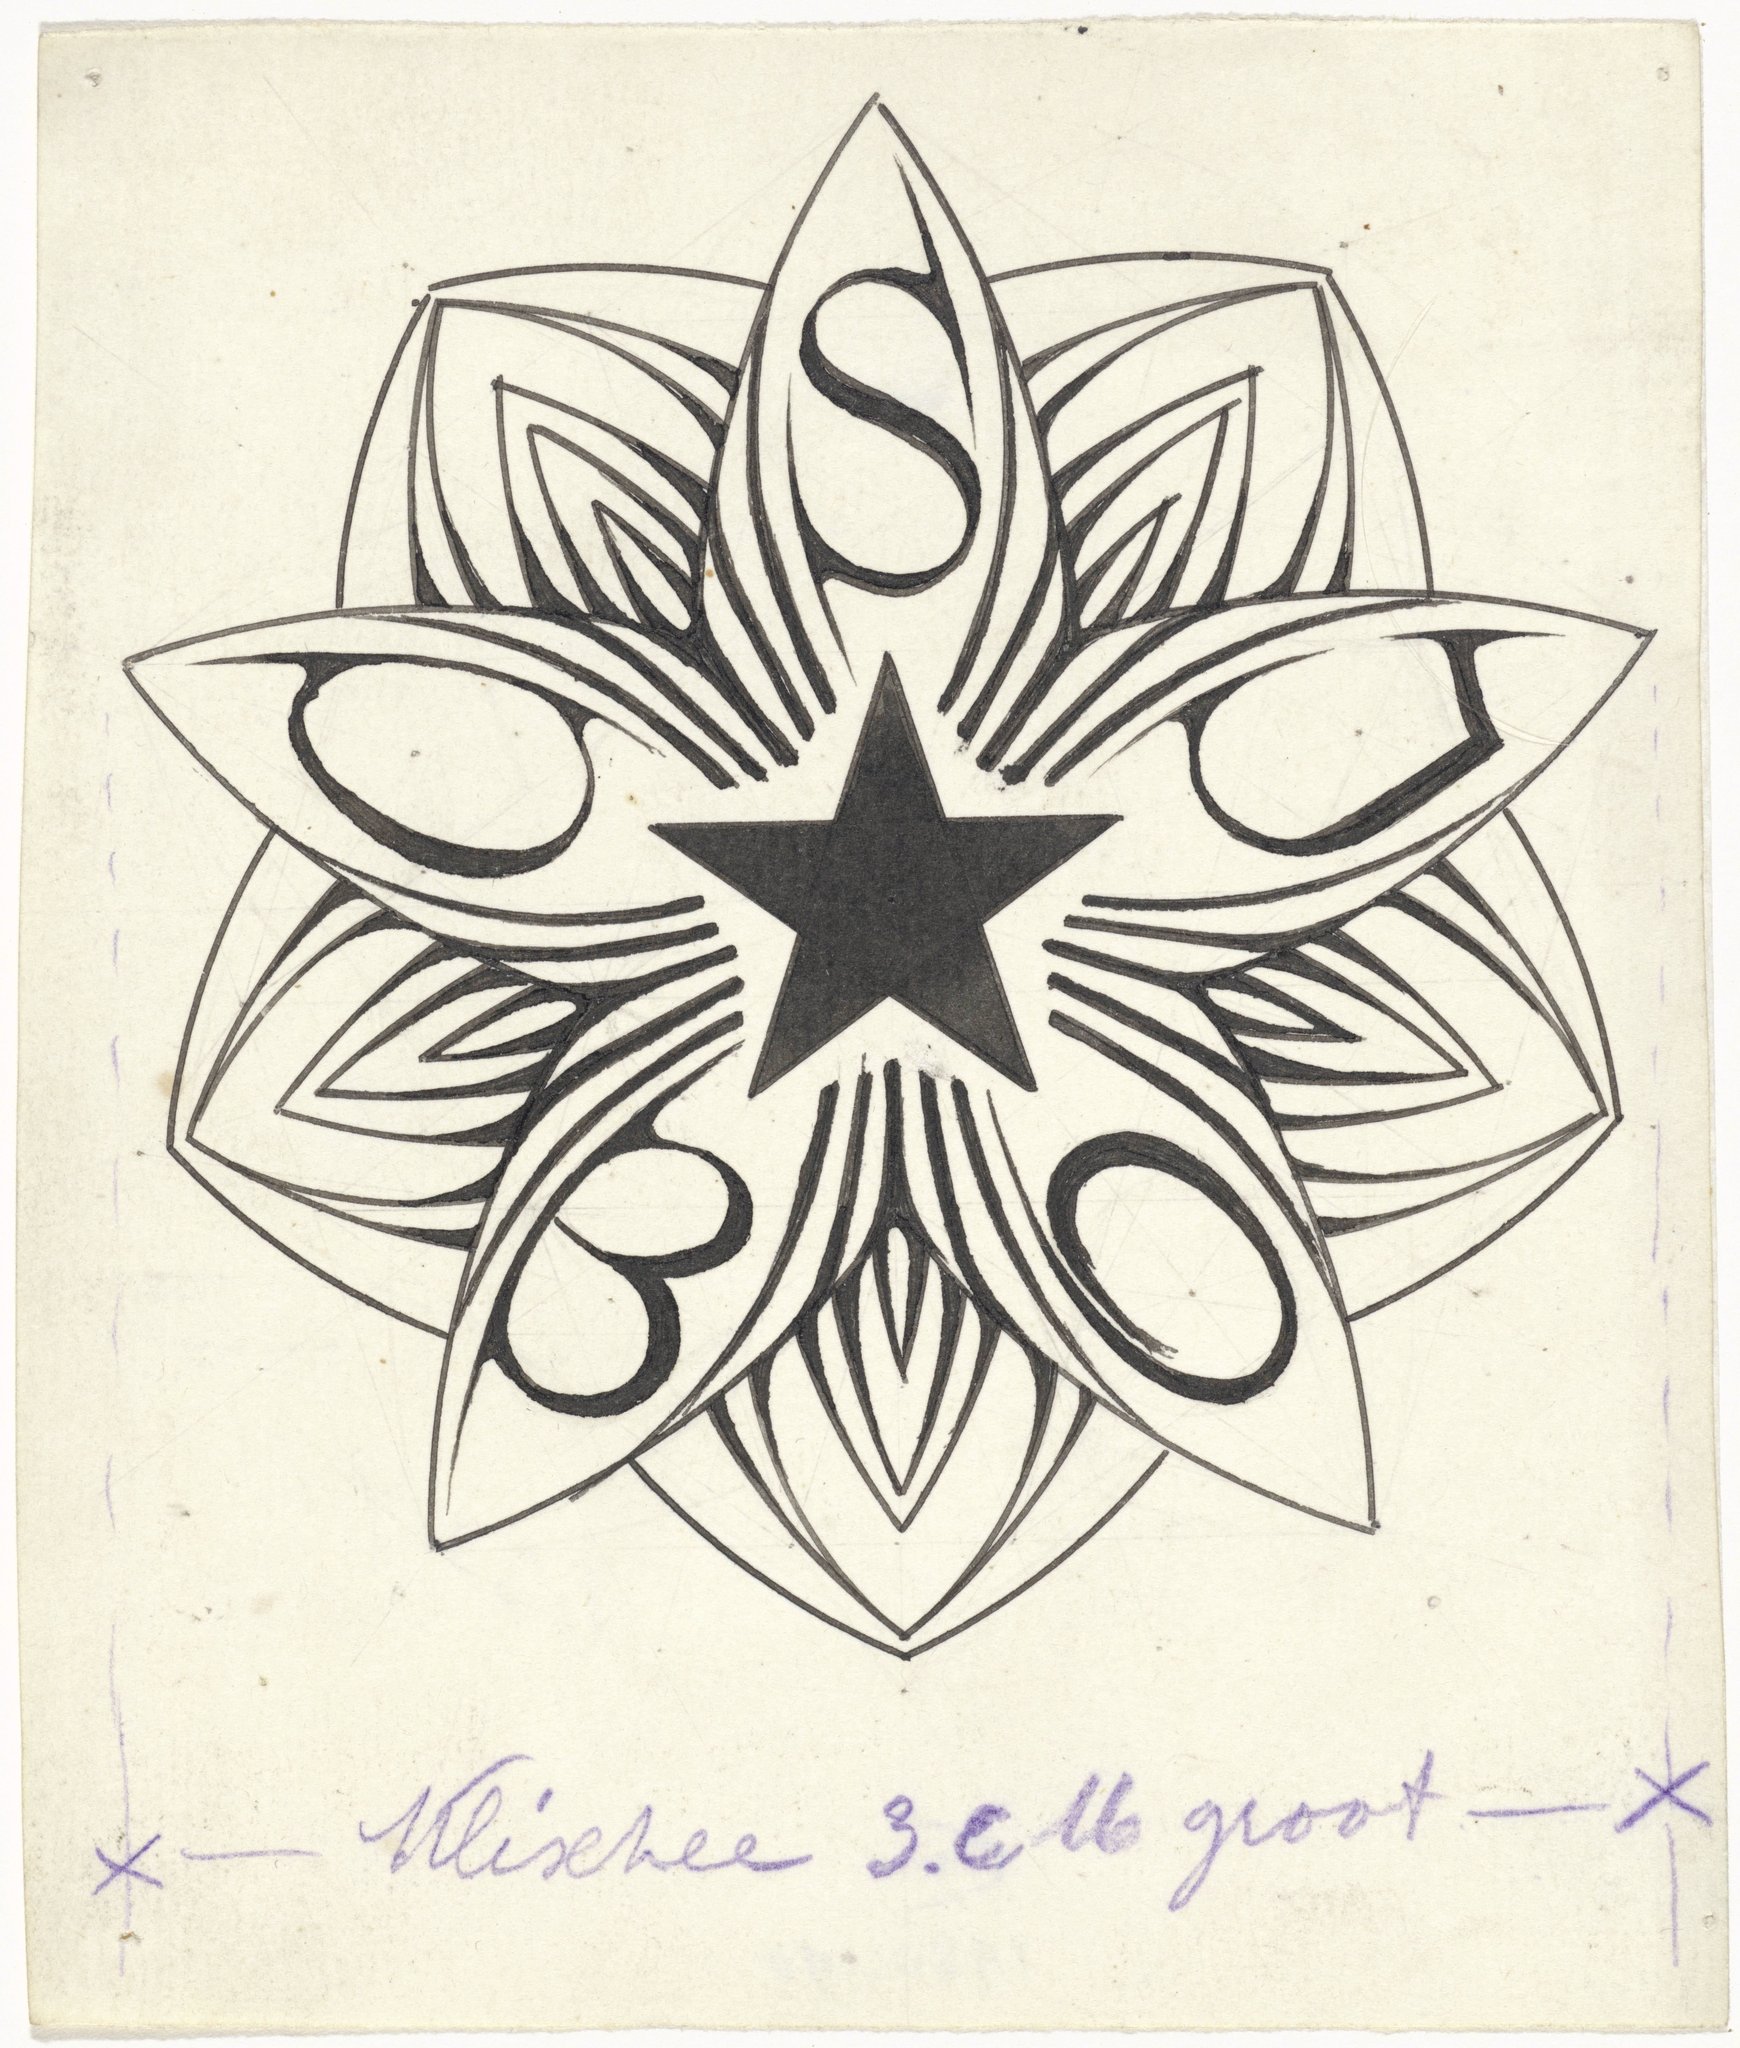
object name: drawing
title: Ontwerp voor een vignet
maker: mathieu lauweriks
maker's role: designer, draughtsman, print maker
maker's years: 1864-1932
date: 1874-1932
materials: ink, paper, pencil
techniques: brush, pen